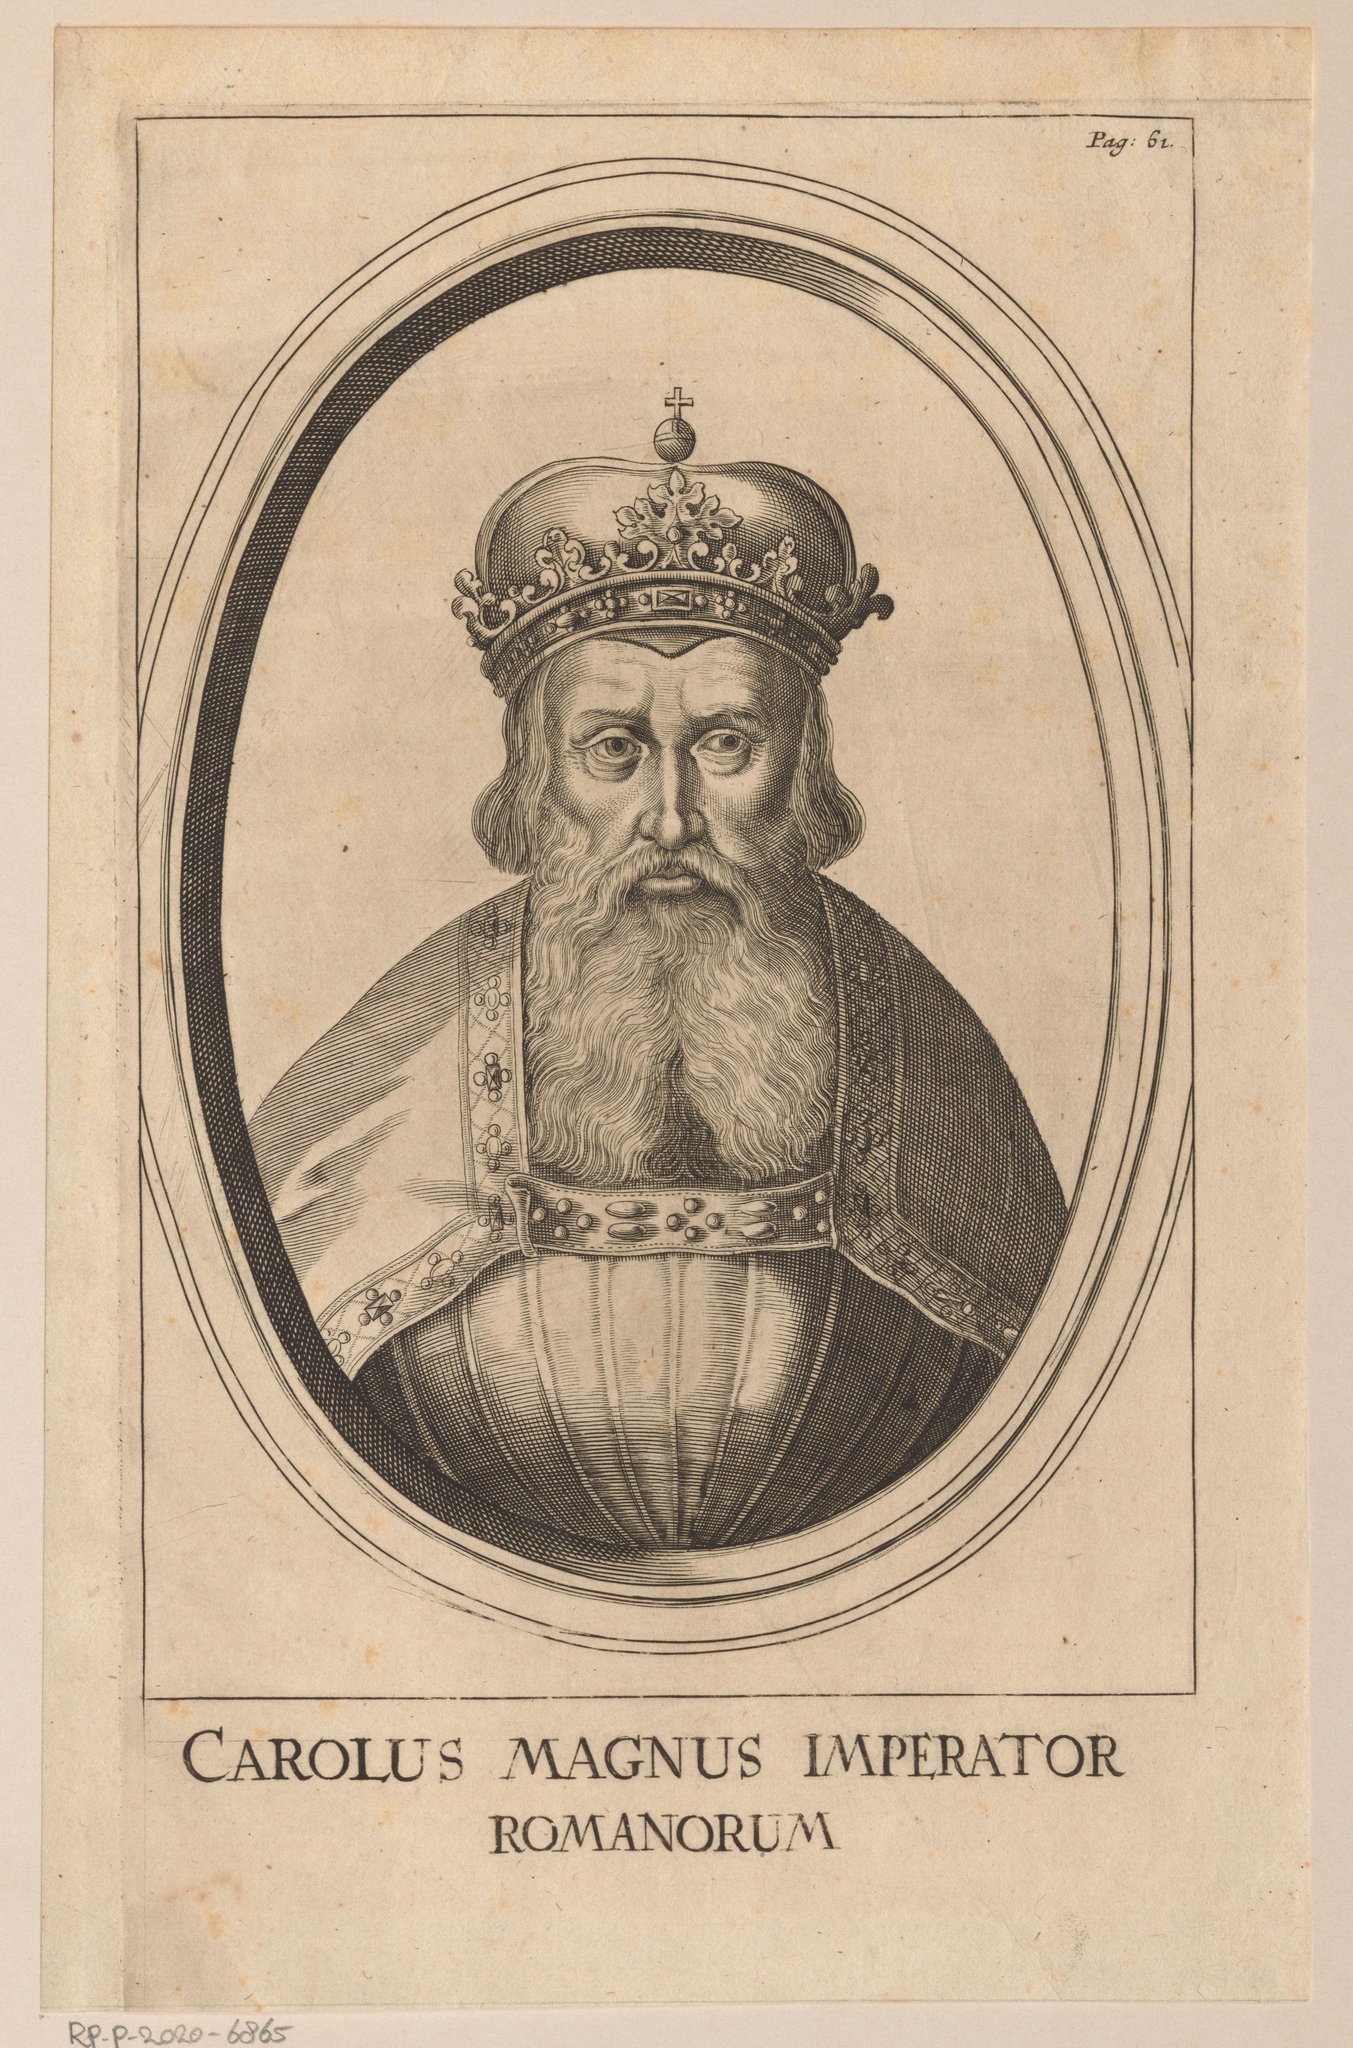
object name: print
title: Portret van Karel de Grote, keizer van het Heilige Roomse Rijk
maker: Anonymous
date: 1660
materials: paper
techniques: engraving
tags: charlemagne (holy roman emperor), historical persons, king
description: Prent mogelijk uit: Schotanus, Christianus. De geschiedenissen kerckelyck ende wereldtlyck van Friesland (...). Amsterdam: Joost Pluymer, 1660.